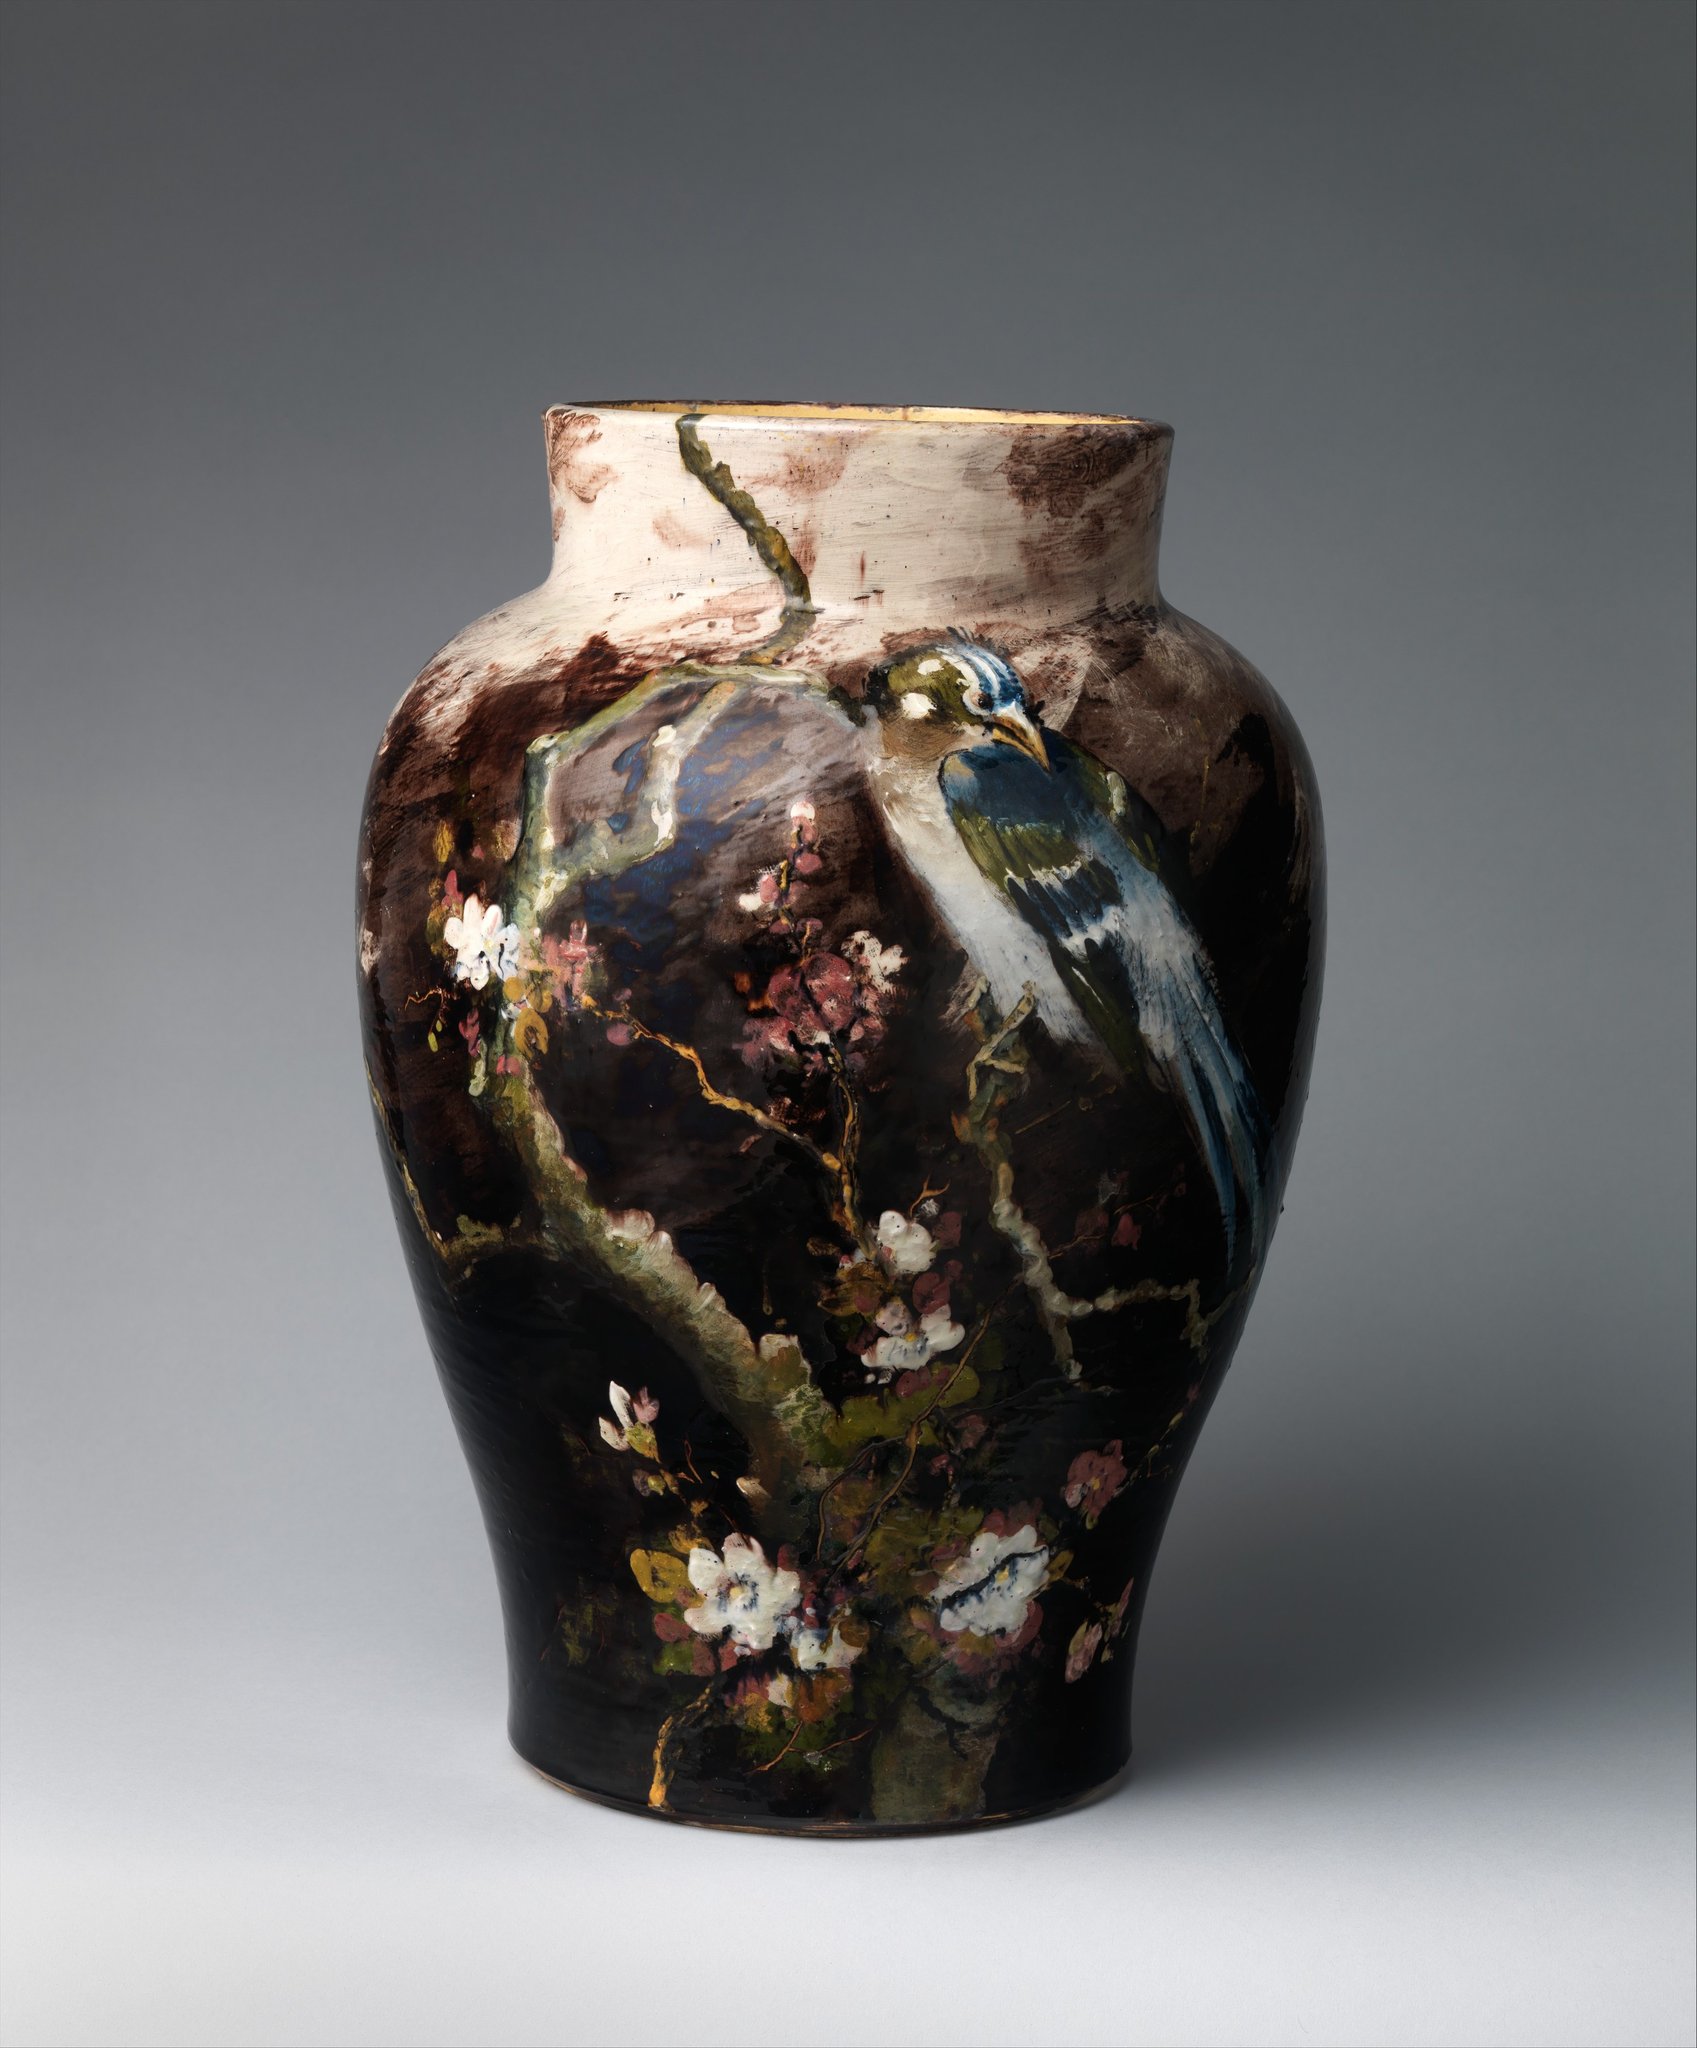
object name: vase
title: Vase with blue jay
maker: françois laurin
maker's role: maker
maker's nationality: french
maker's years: 1826-1901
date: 1880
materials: stoneware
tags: birds,flowers